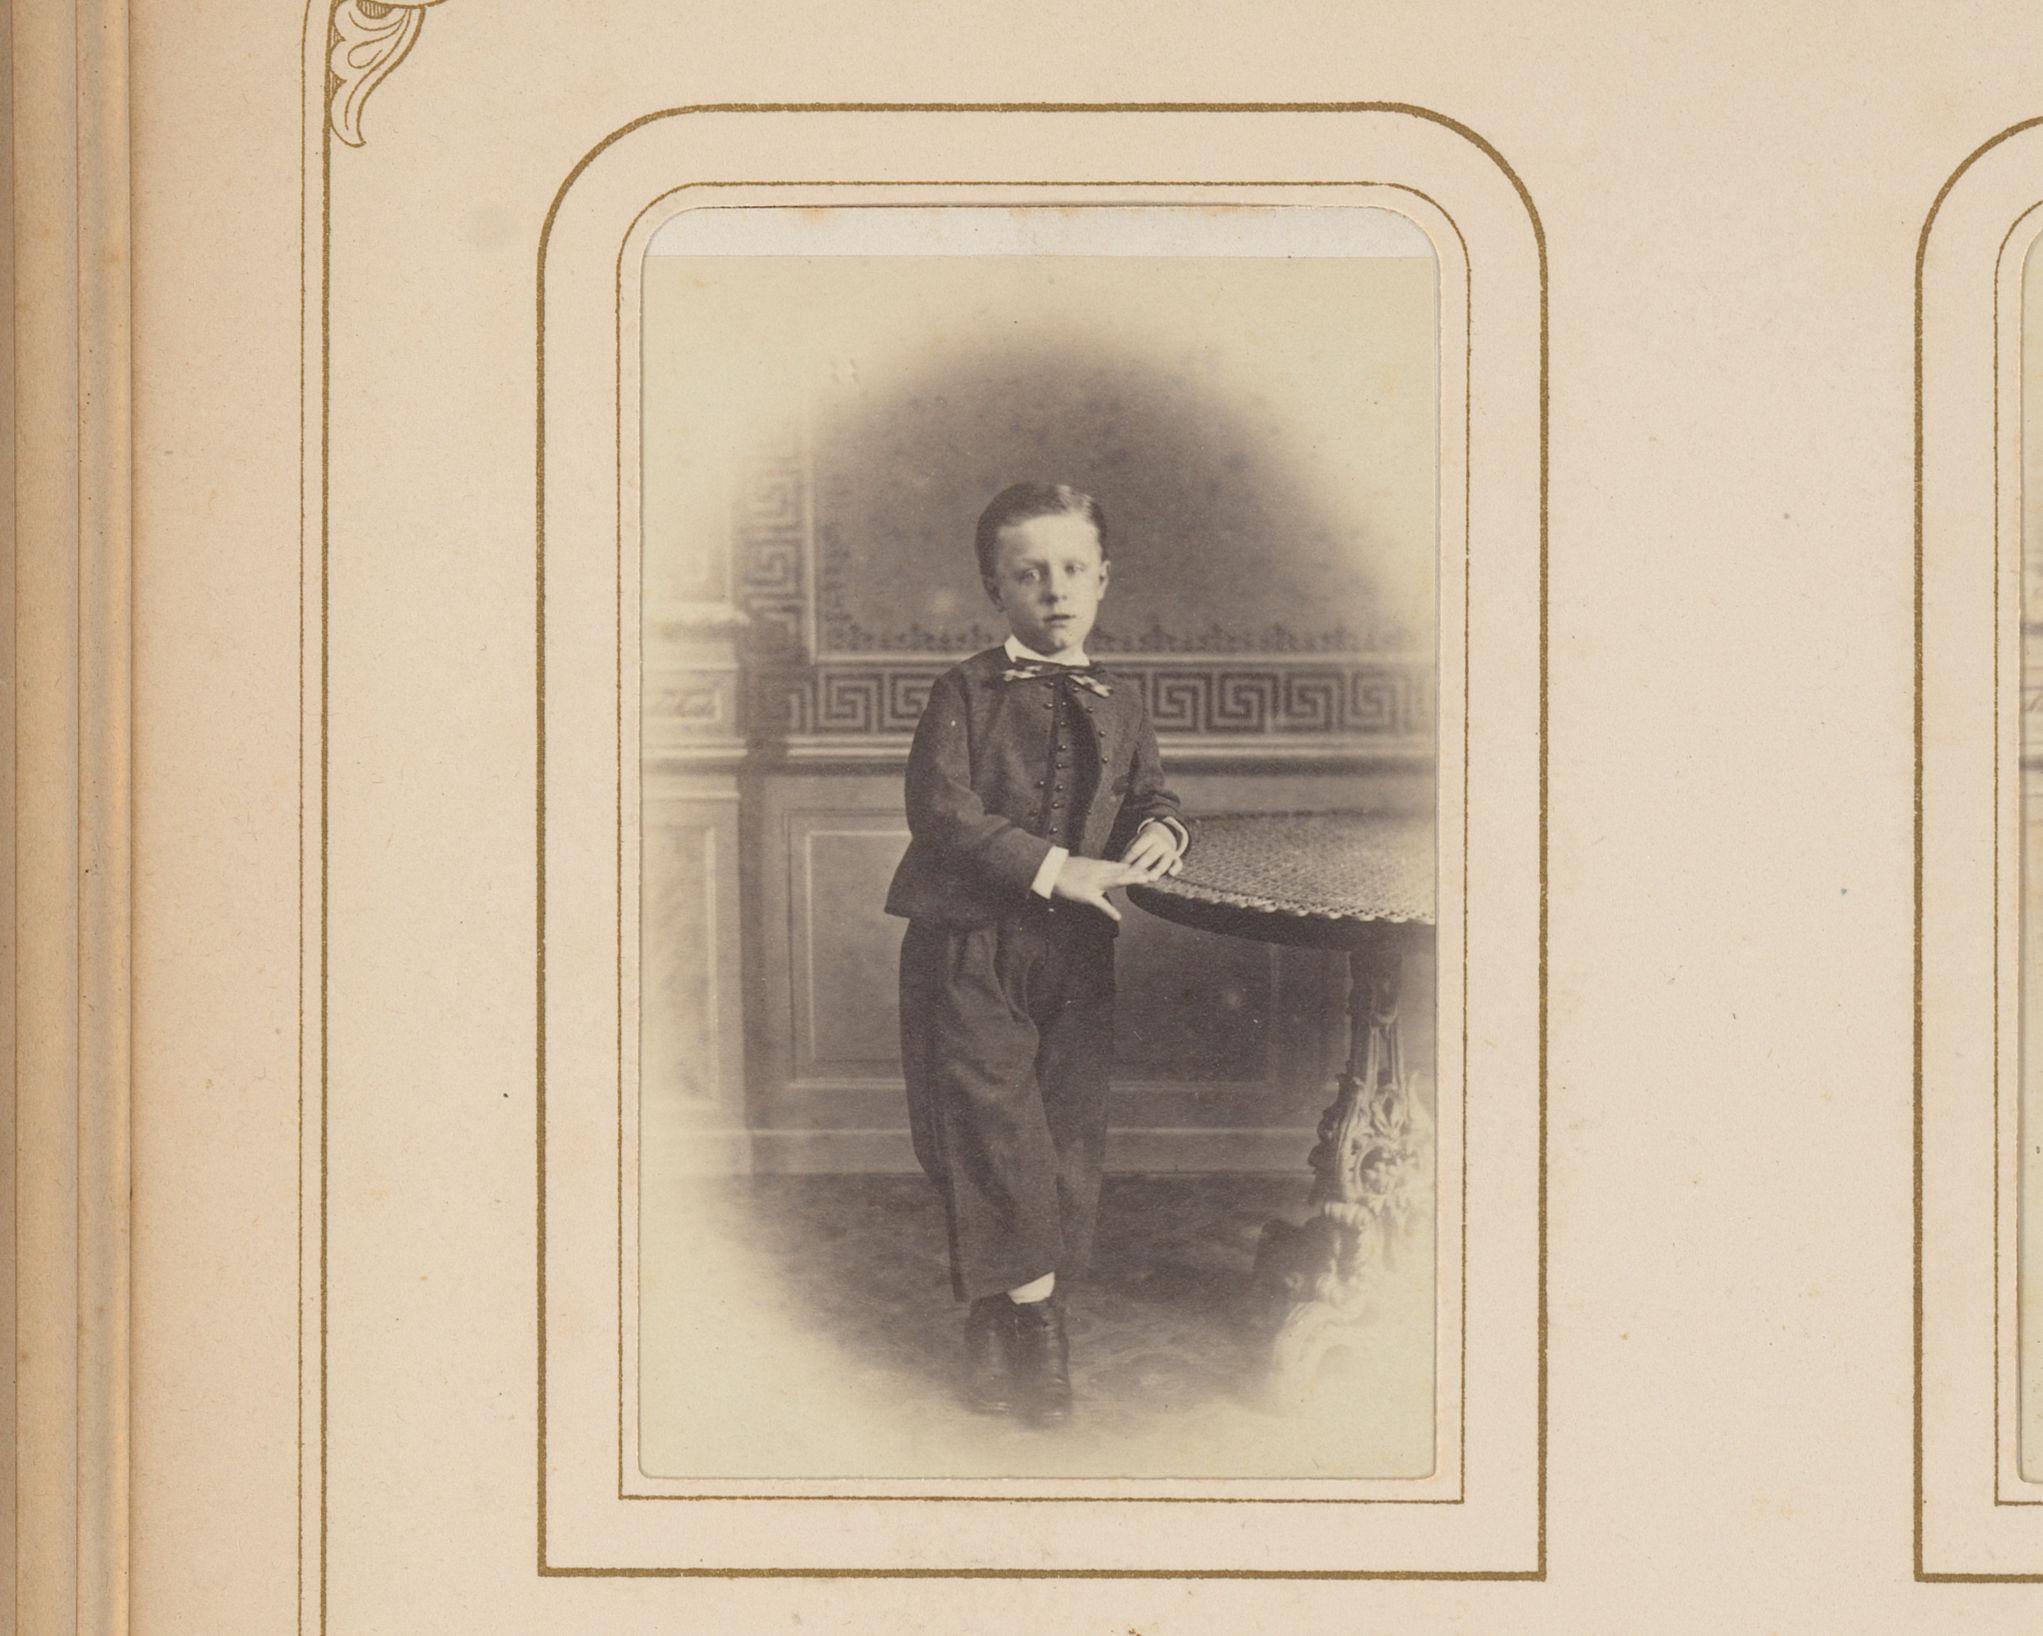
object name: photograph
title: Portret van een jongen, leunend op een tafel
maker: Anonymous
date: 1850-1900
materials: cardboard, photographic support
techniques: albumen print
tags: boy (child between toddler and youth), historical persons, table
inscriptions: monogram: ‘FR’